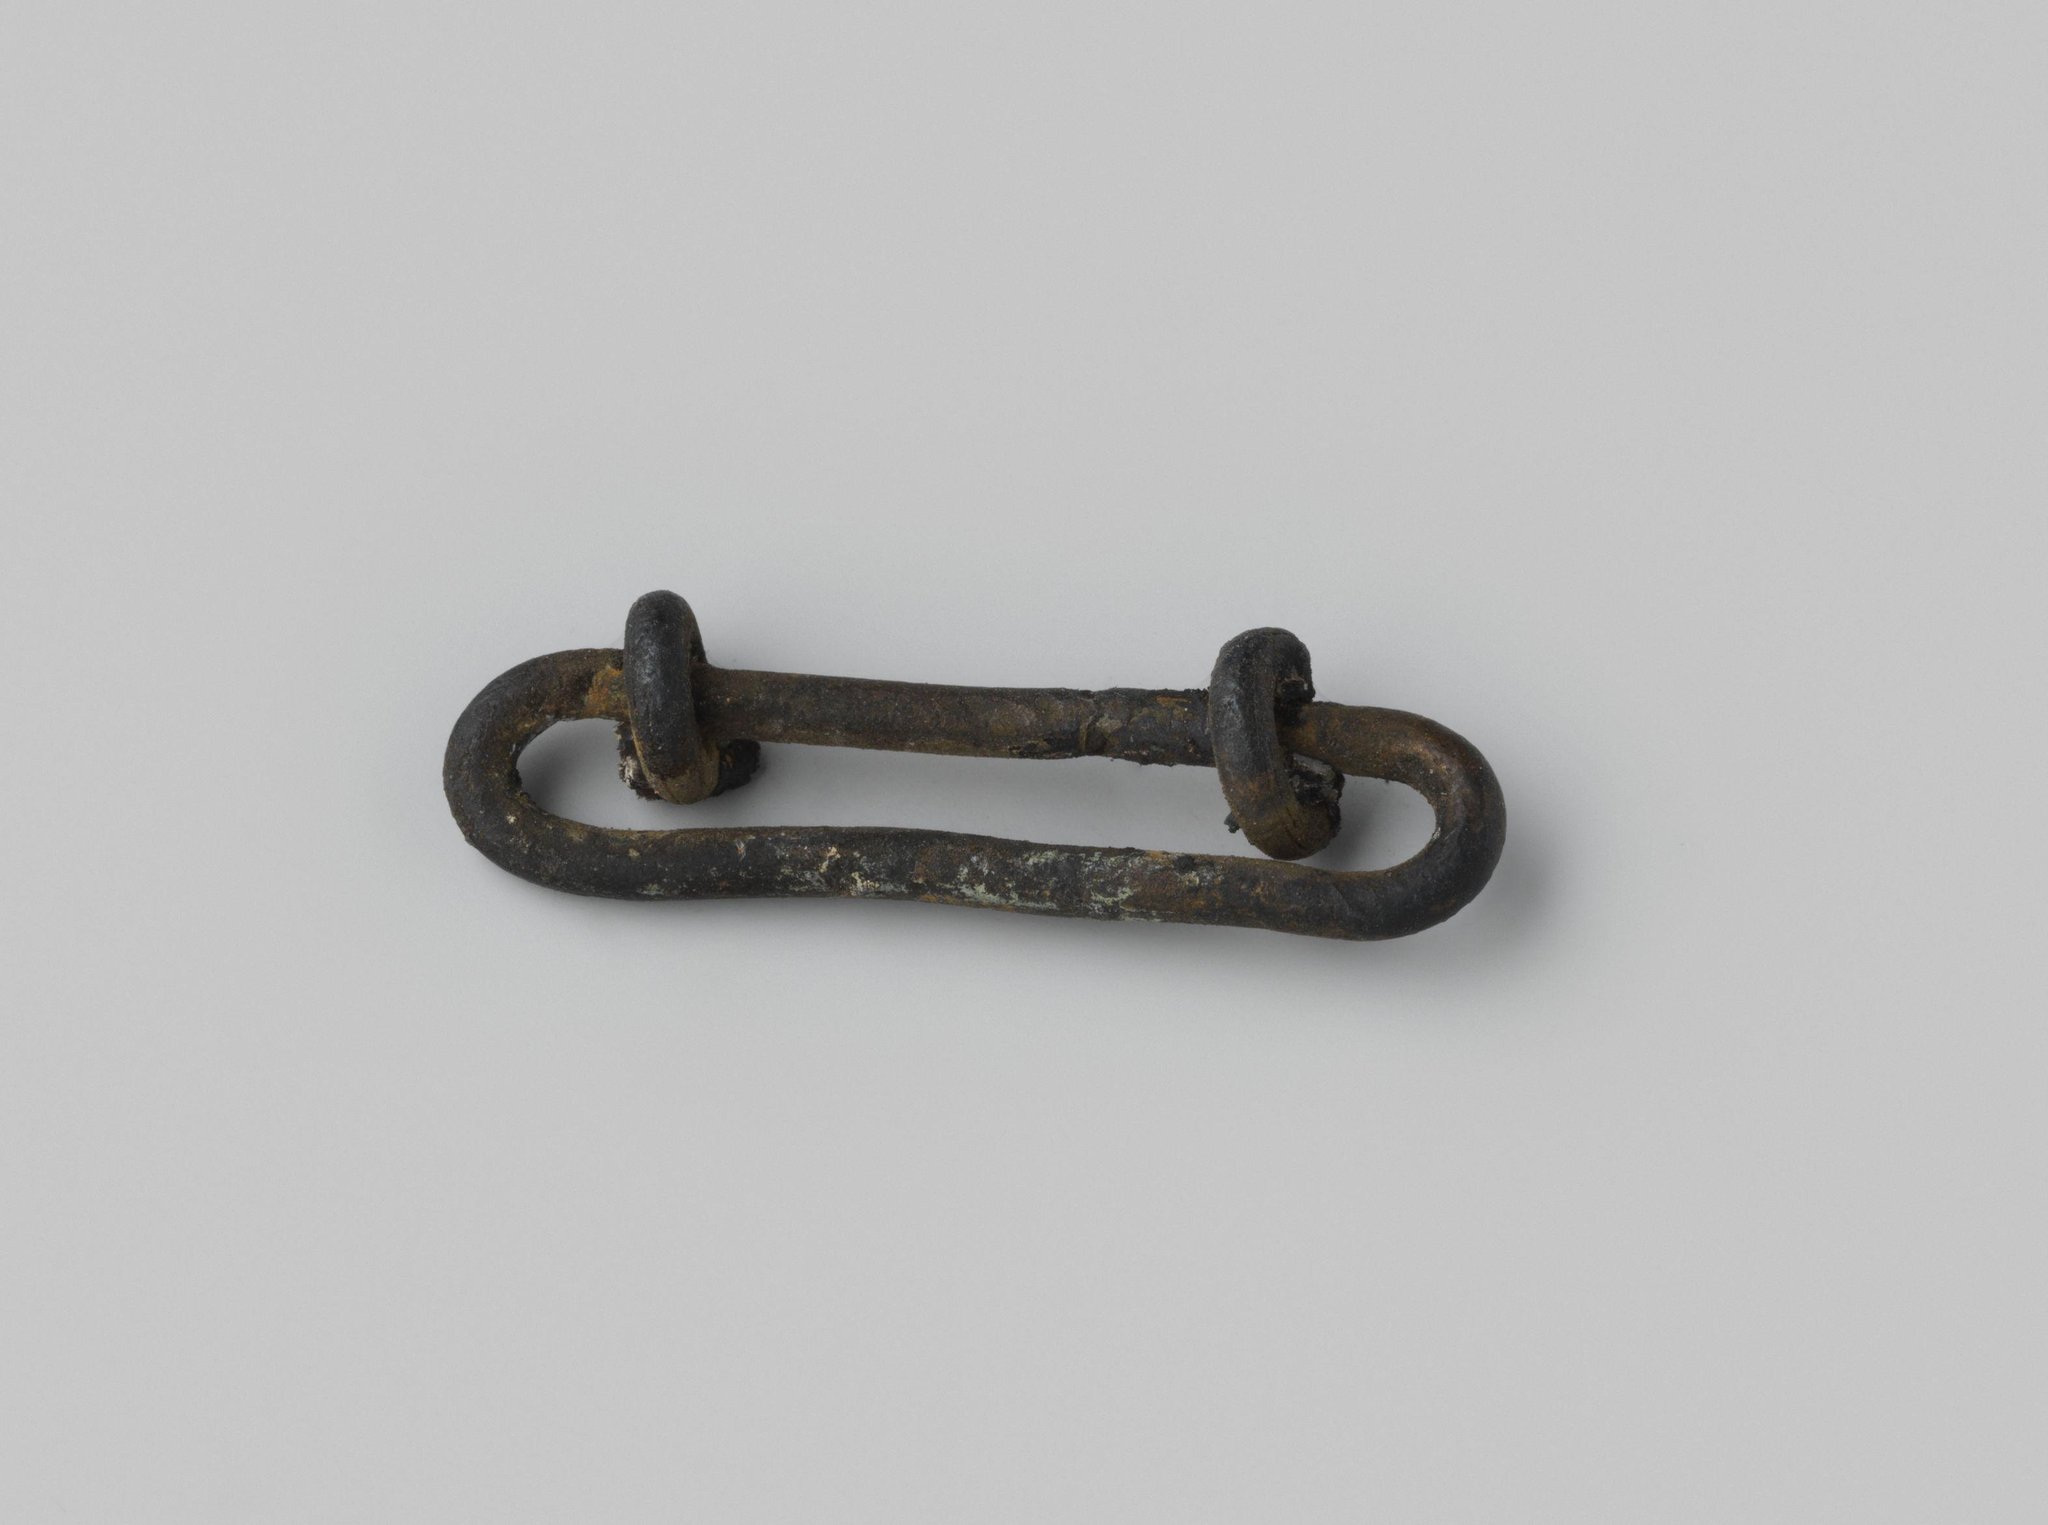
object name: scharnier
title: Scharnier uit het wrak van de Oost-Indiëvaarder Hollandia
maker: Anonymous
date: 1700-1743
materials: copper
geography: netherlands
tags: verenigde oostindische compagnie, hollandia (schip), annet